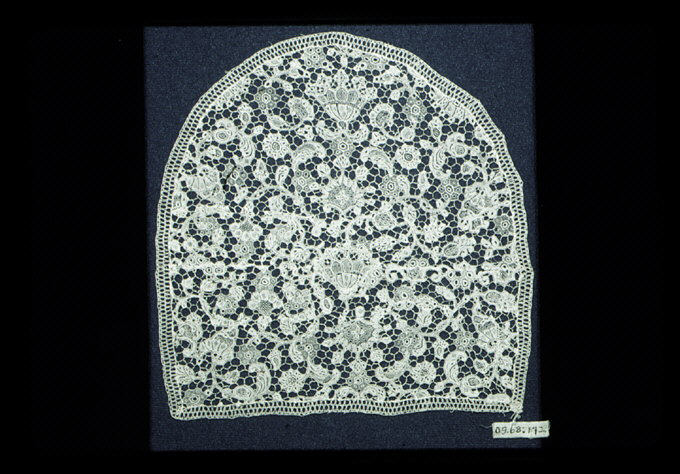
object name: cap crown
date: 1701-1800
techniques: lace